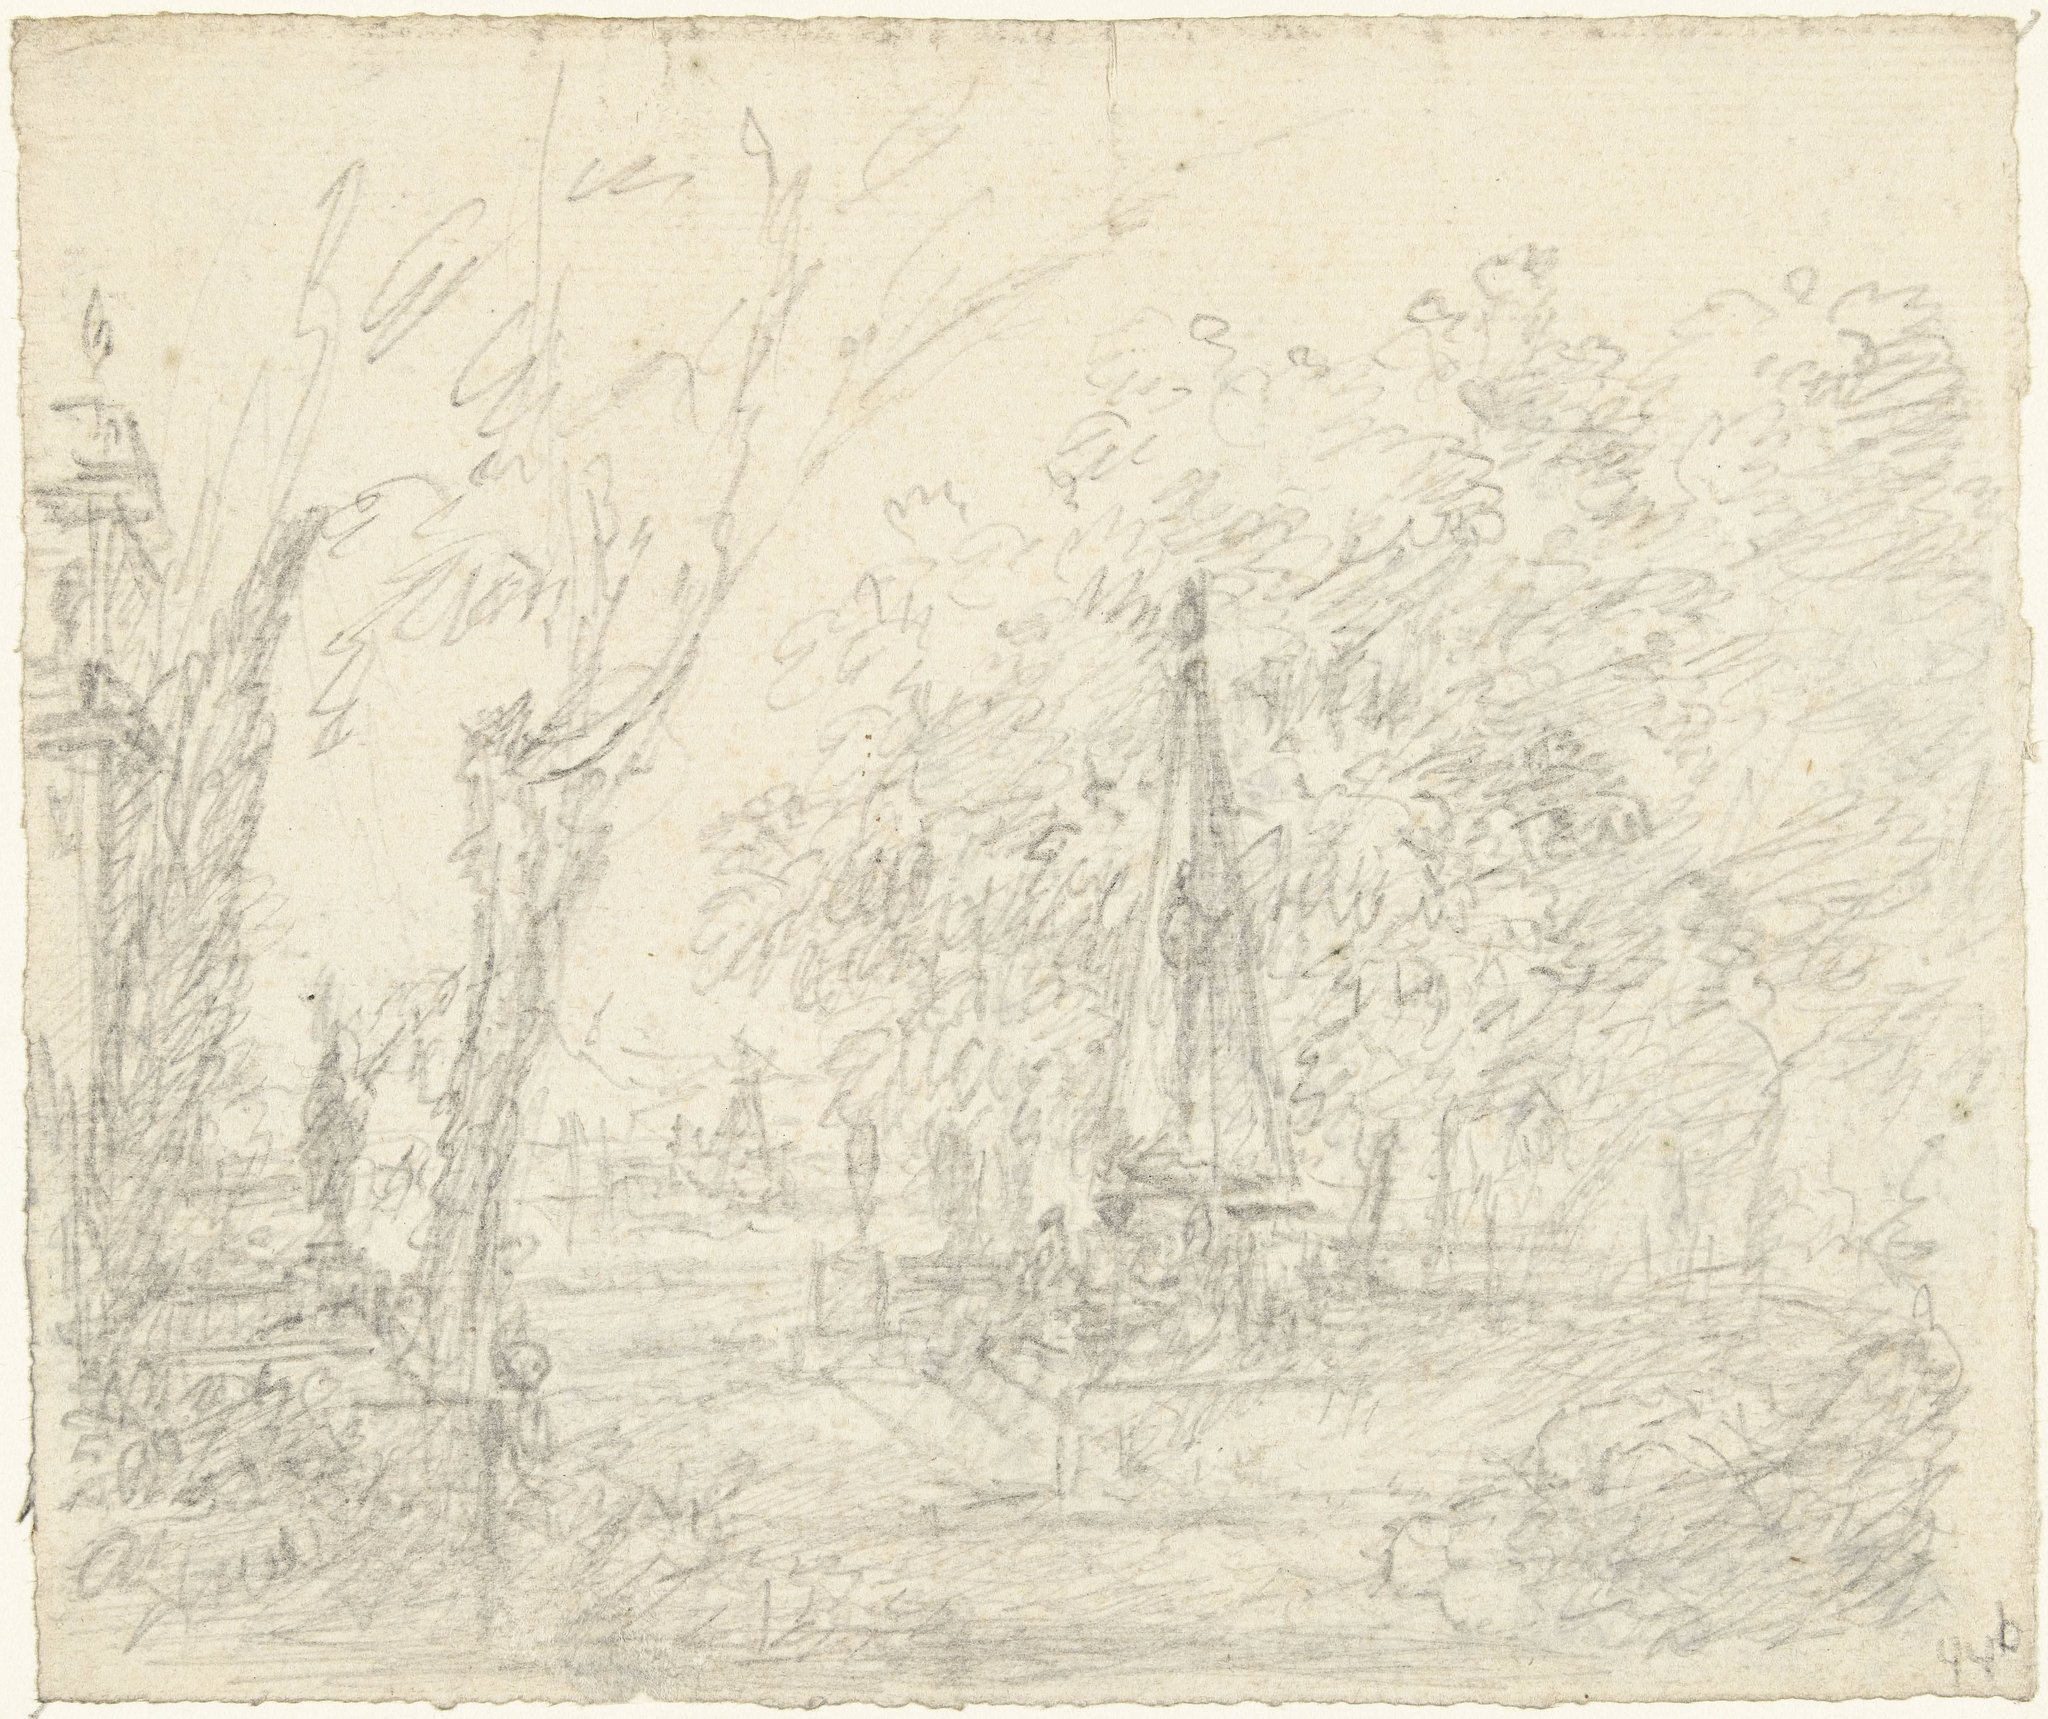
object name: design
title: Tuin met obelisk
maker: dionys van nijmegen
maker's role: draughtsman, painter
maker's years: 1705-1798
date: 1715-1798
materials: paper, pencil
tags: garden